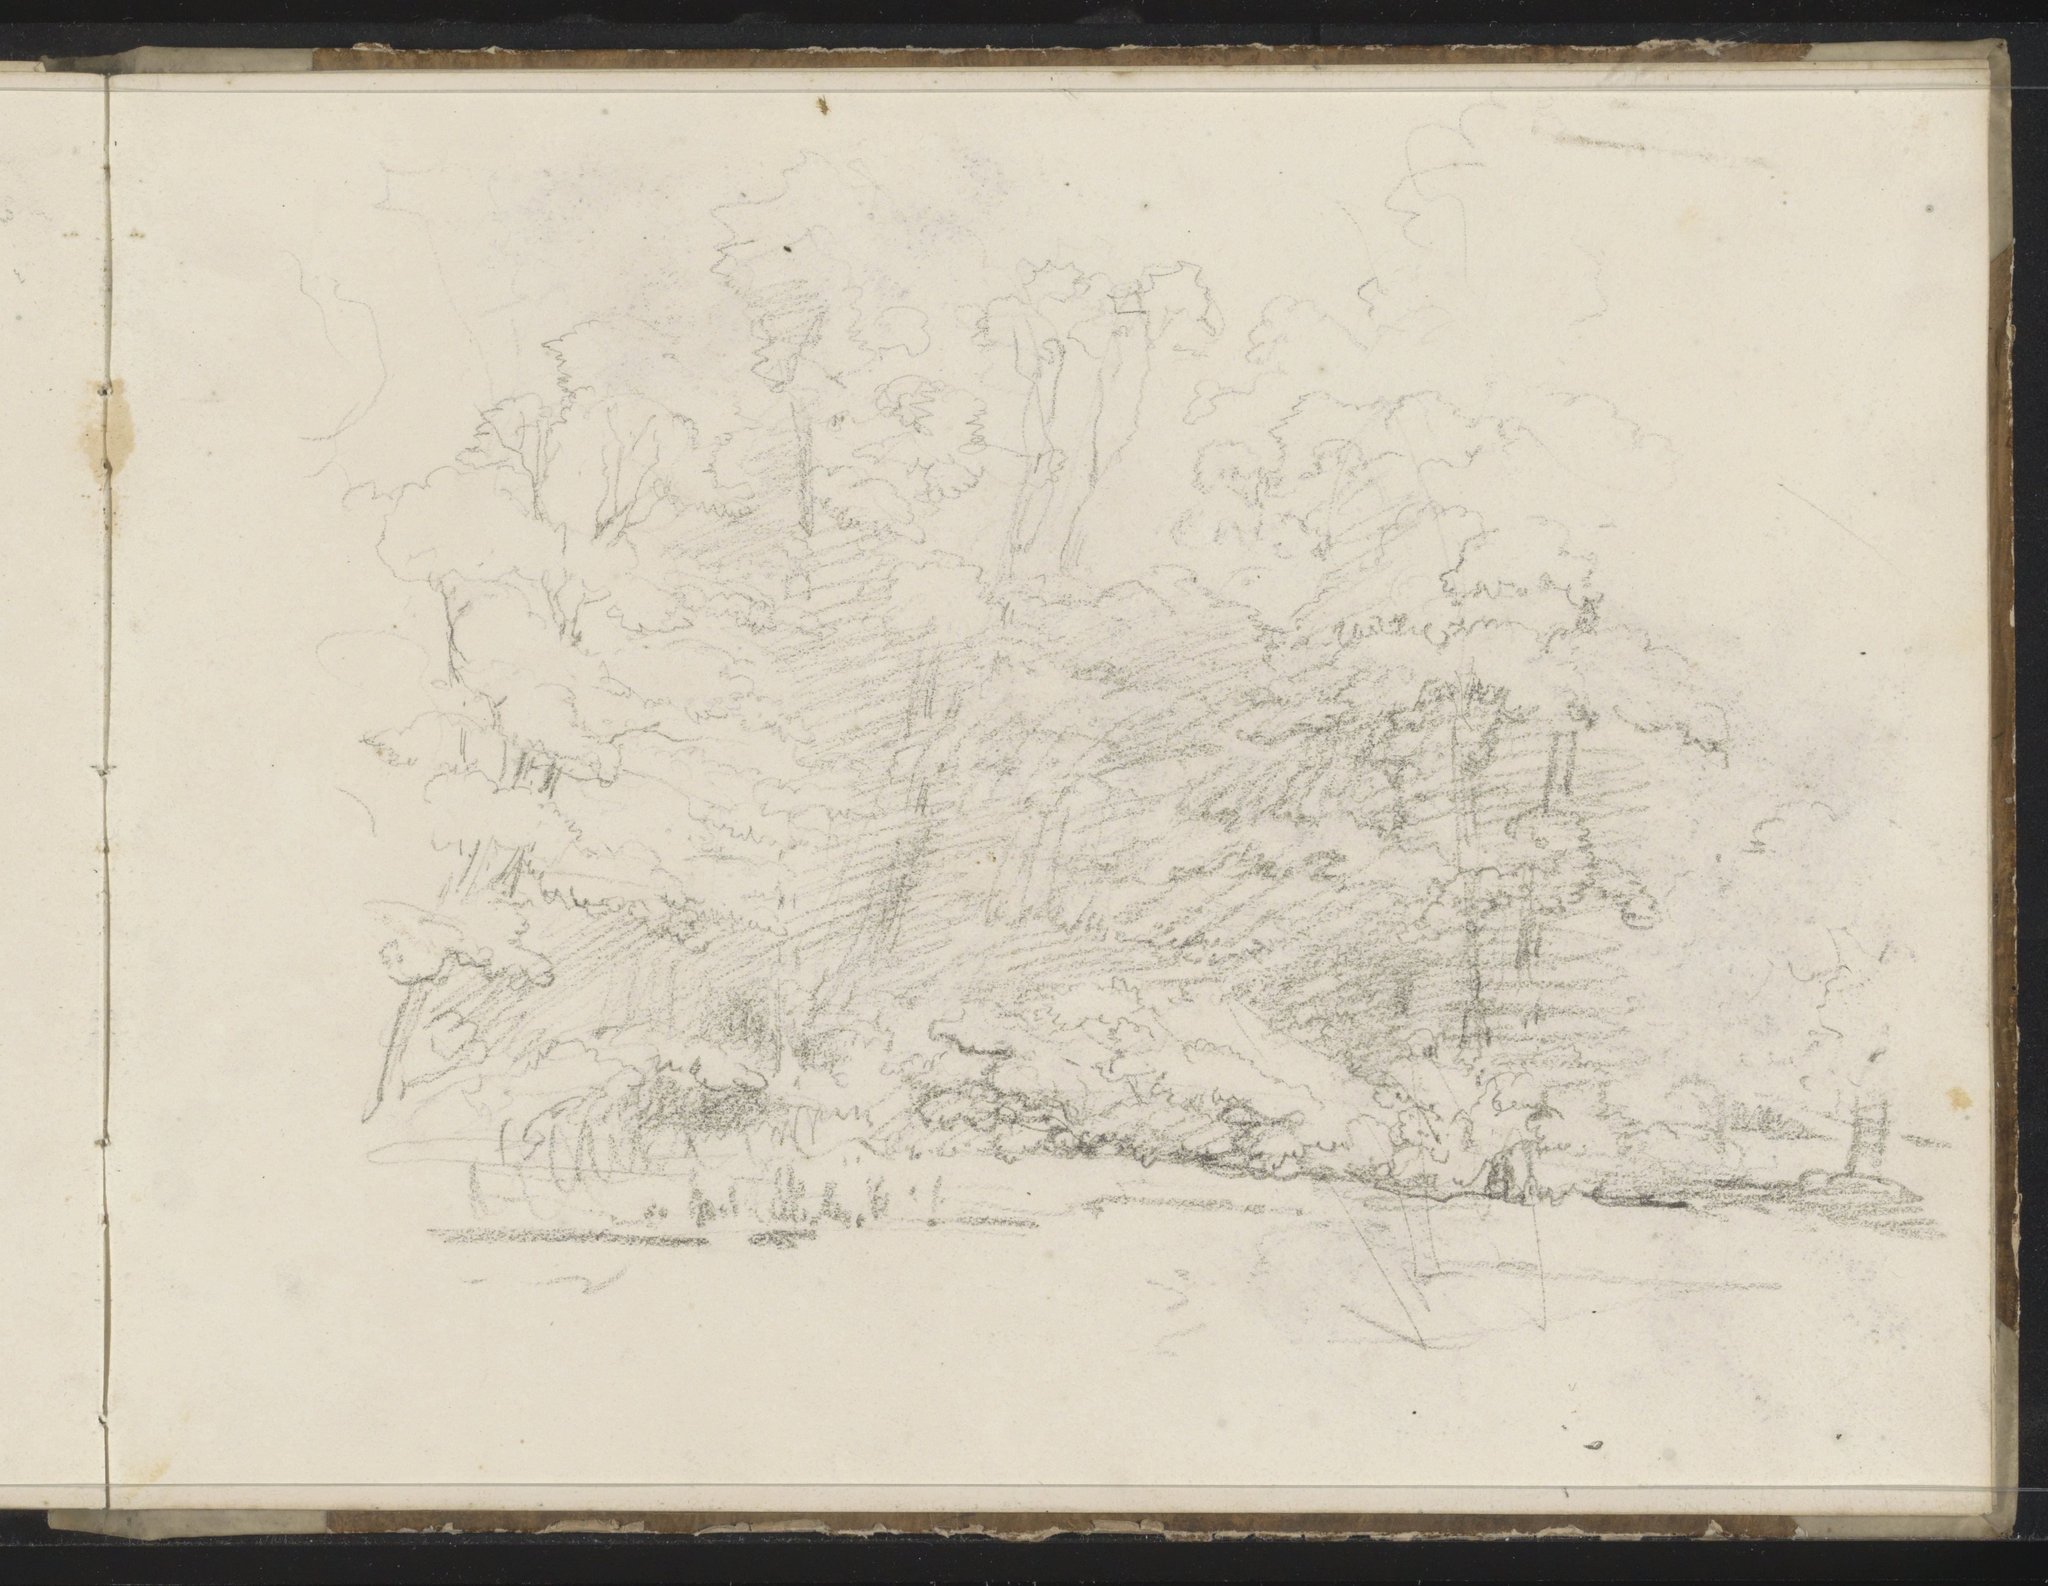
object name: sketchbook leaf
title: Bos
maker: maria vos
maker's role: draughtsman, painter, print maker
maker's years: 1824-1906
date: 1834-1906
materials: chalk, paper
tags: forest, wood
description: Blad 38 recto uit een schetsboek met 39 bladen.